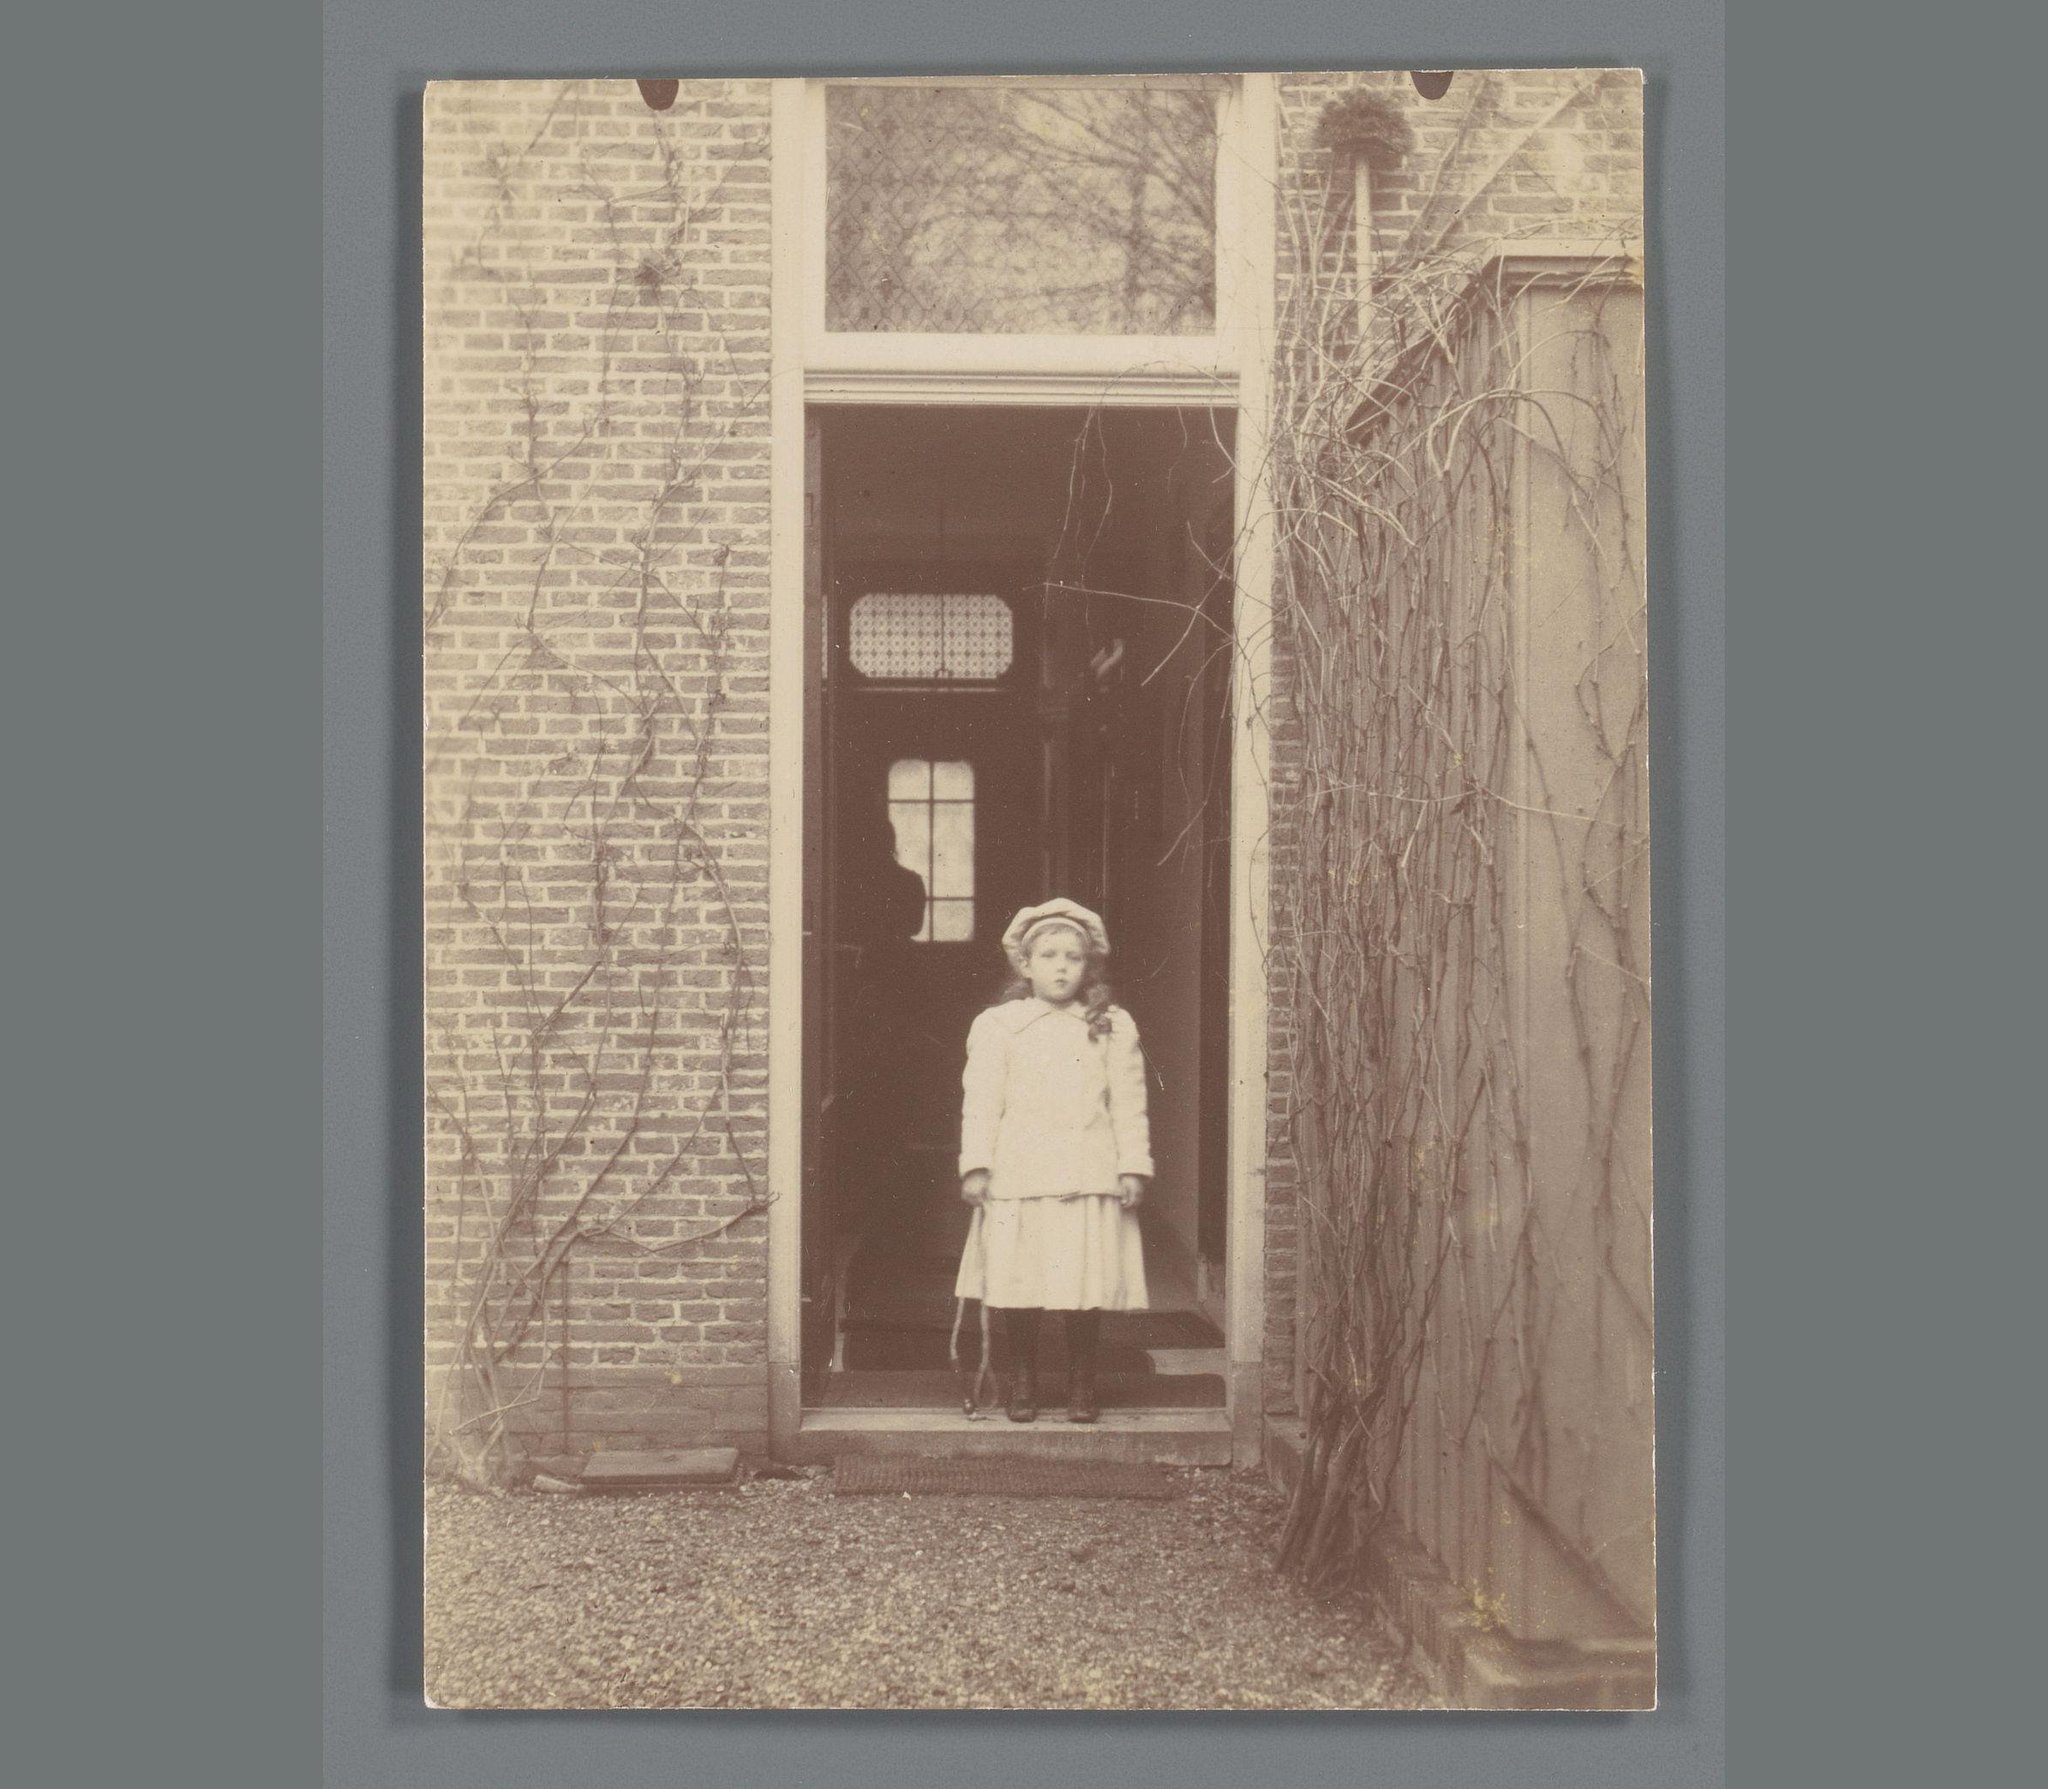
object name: photograph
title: Portret van Johanna (Hans) de Jong in de deuropening van het huis van Willem de Jong in Leiden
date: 1900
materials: paper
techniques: gelatin silver print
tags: leiden, johanna petronella lambertina stokhuyzen-de jong (hans), historical persons not known by name - bb - woman, stile, post, doorjamb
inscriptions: address: ‘Noordeinde 46’, name: ‘H.’